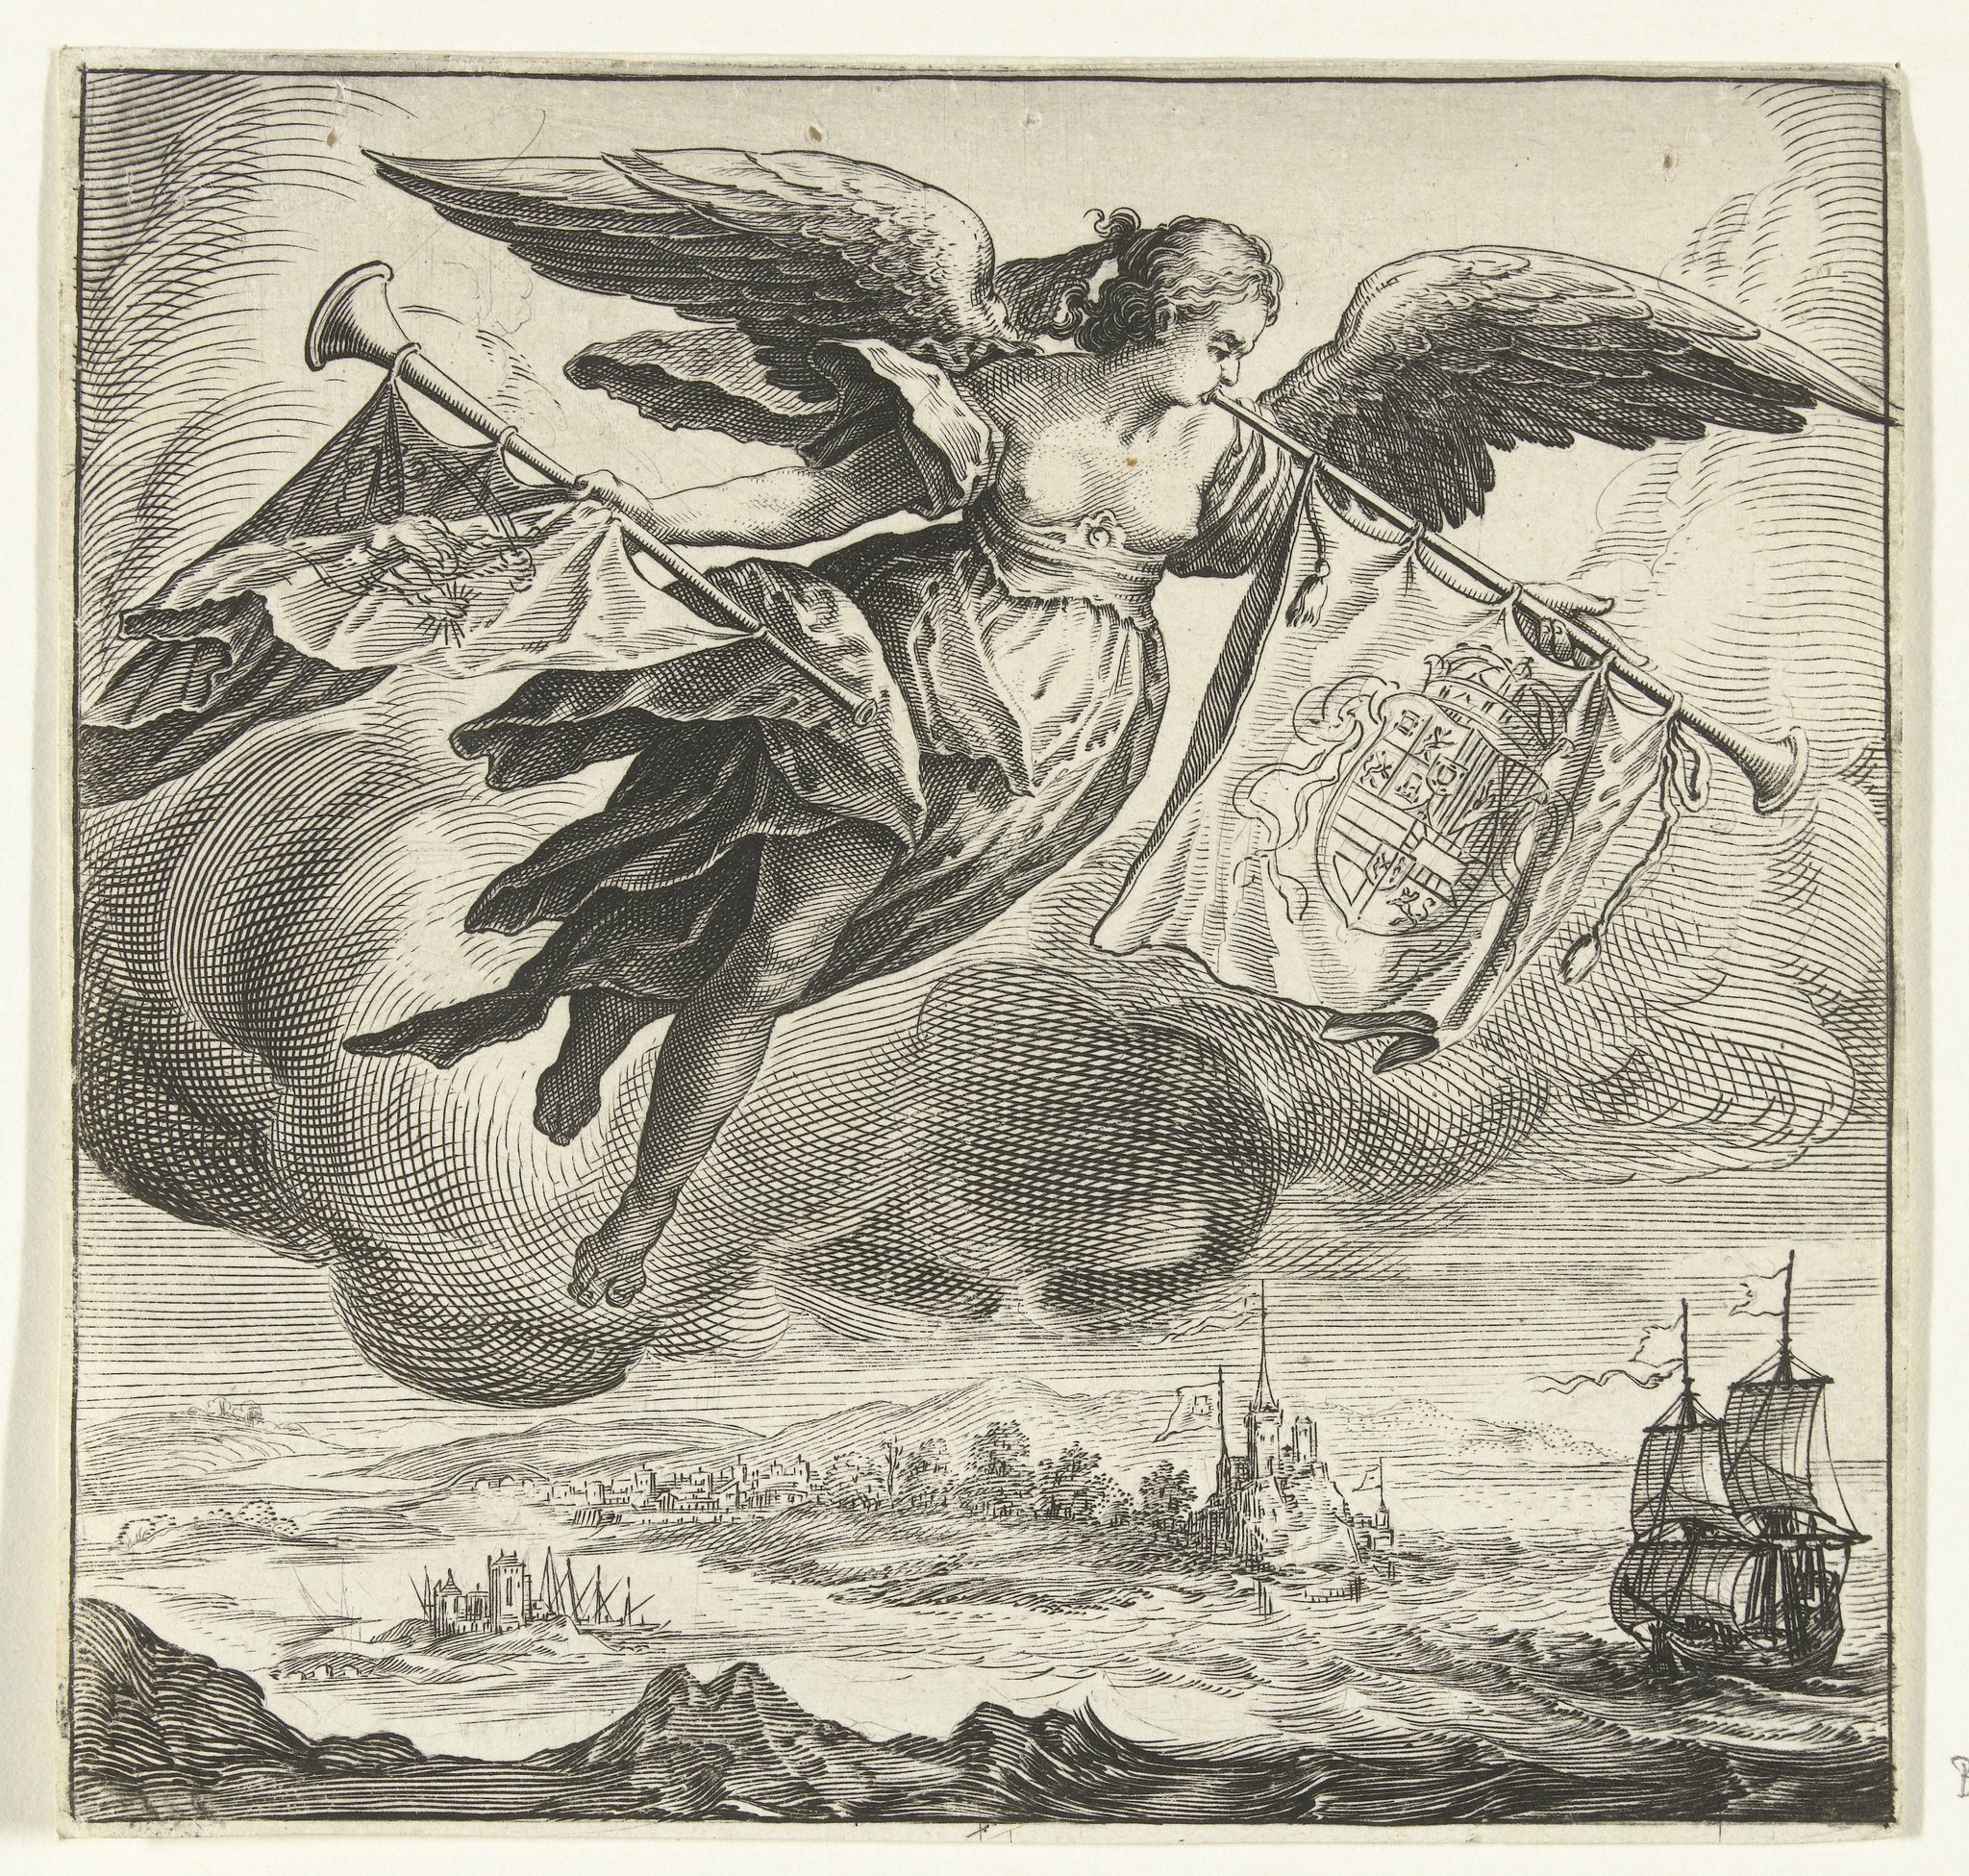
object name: print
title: De zes vertooningen die op de schouburg (...) vertoont zijn den 23 iunij 1648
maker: salomon savery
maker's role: print maker, publisher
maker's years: 1594-1683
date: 1649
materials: paper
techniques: engraving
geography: northern netherlands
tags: fame; 'fama', 'fama buona', 'fama chiara' (ripa), amsterdam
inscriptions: collector's mark: Lugt 240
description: Prent voor de titelpagina voor de uitgave van zes prenten met voorstellingen van de vertoningen die opgevoerd zijn op de Schouwburg te Amsterdam op 23 juni 1648 naar aanleiding van het sluiten van de Vrede van Munster. Faam boven een kustlandschap met bazuinen met de wapens van Spanje en de Republiek.